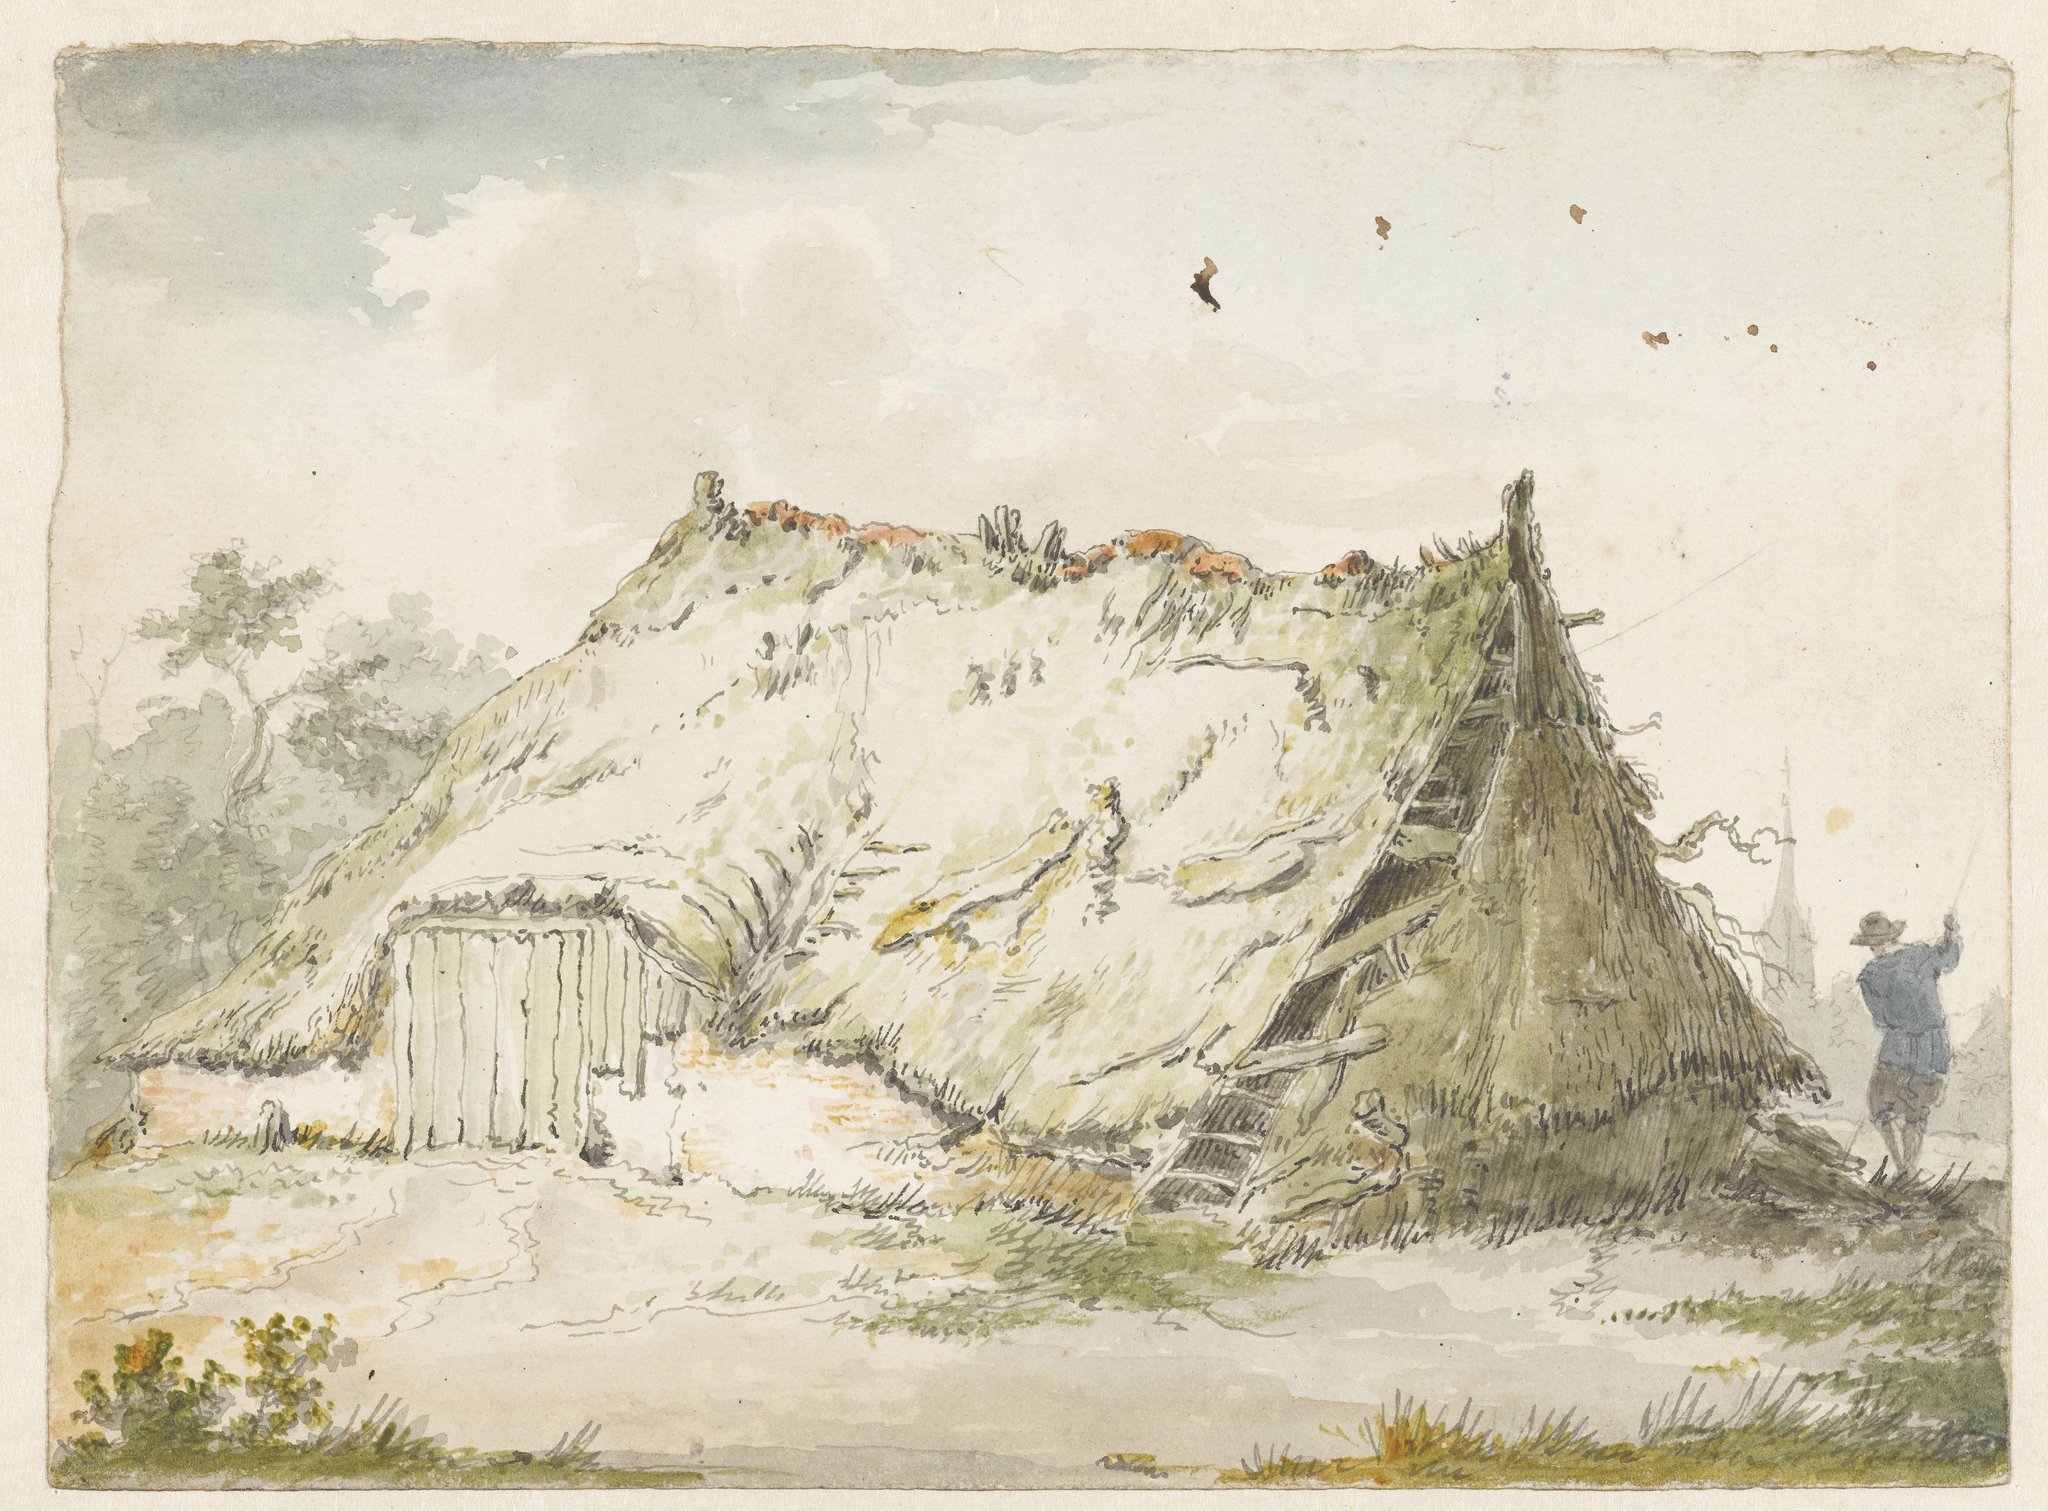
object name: drawing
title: Bouwvallige boerderij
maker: pieter bartholomeusz. barbiers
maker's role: draughtsman, print maker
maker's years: 1772-1837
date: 1782-1837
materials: graphite, ink, paper, watercolor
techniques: brush, pen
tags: farm or solitary house in landscape